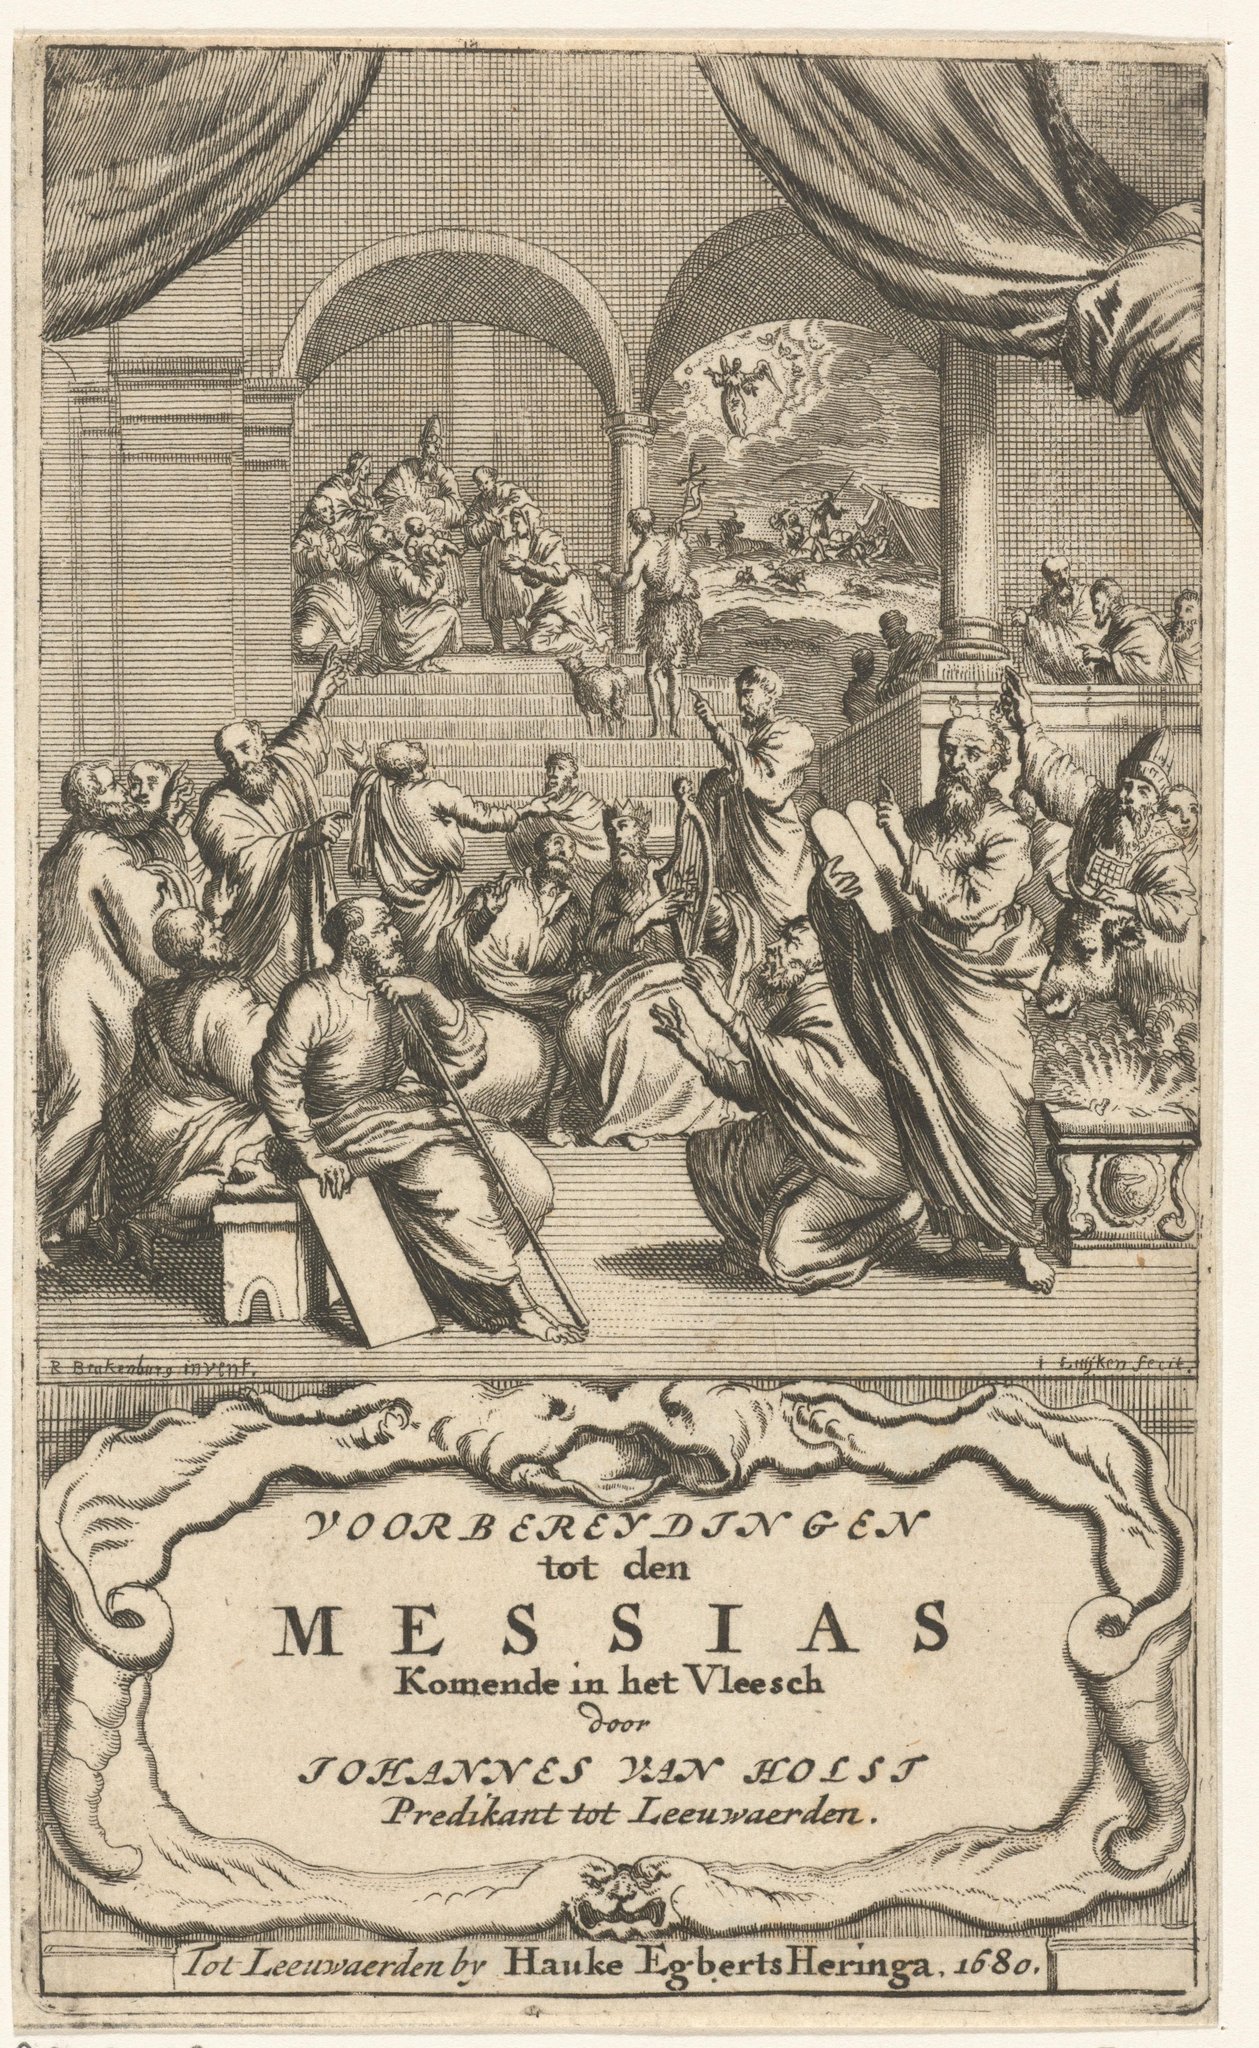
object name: print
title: Bijeenkomst van oudtestamentische figuren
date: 1680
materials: paper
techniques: etching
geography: amsterdam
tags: annunciation of christ's birth to the shepherds (and/or shepherdesses) at night; a host of singing angels in the air, david (not in biblical context); possible attributes: crown, harp, aaron (not in biblical context); possible attributes: attributes of aaron: censer, dressed as high priest or bishop, ointment jar, rod or flowering wand, moses (not in biblical context); possible attributes: rays of light or horns on his head, rod, tables of the law, groups of persons from the old testament, presentation of the christ-child in the temple, usually simeon (and anna) present (luke 2:22-39)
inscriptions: collector's mark: Lugt 2228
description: Mozes, Aäron, David en andere oudtestamentische figuren zijn bijeengekomen in een zaal en wijzen naar twee nissen op de achtergrond waarin de verkondiging aan de herders en de presentatie in de tempel zijn afgebeeld.